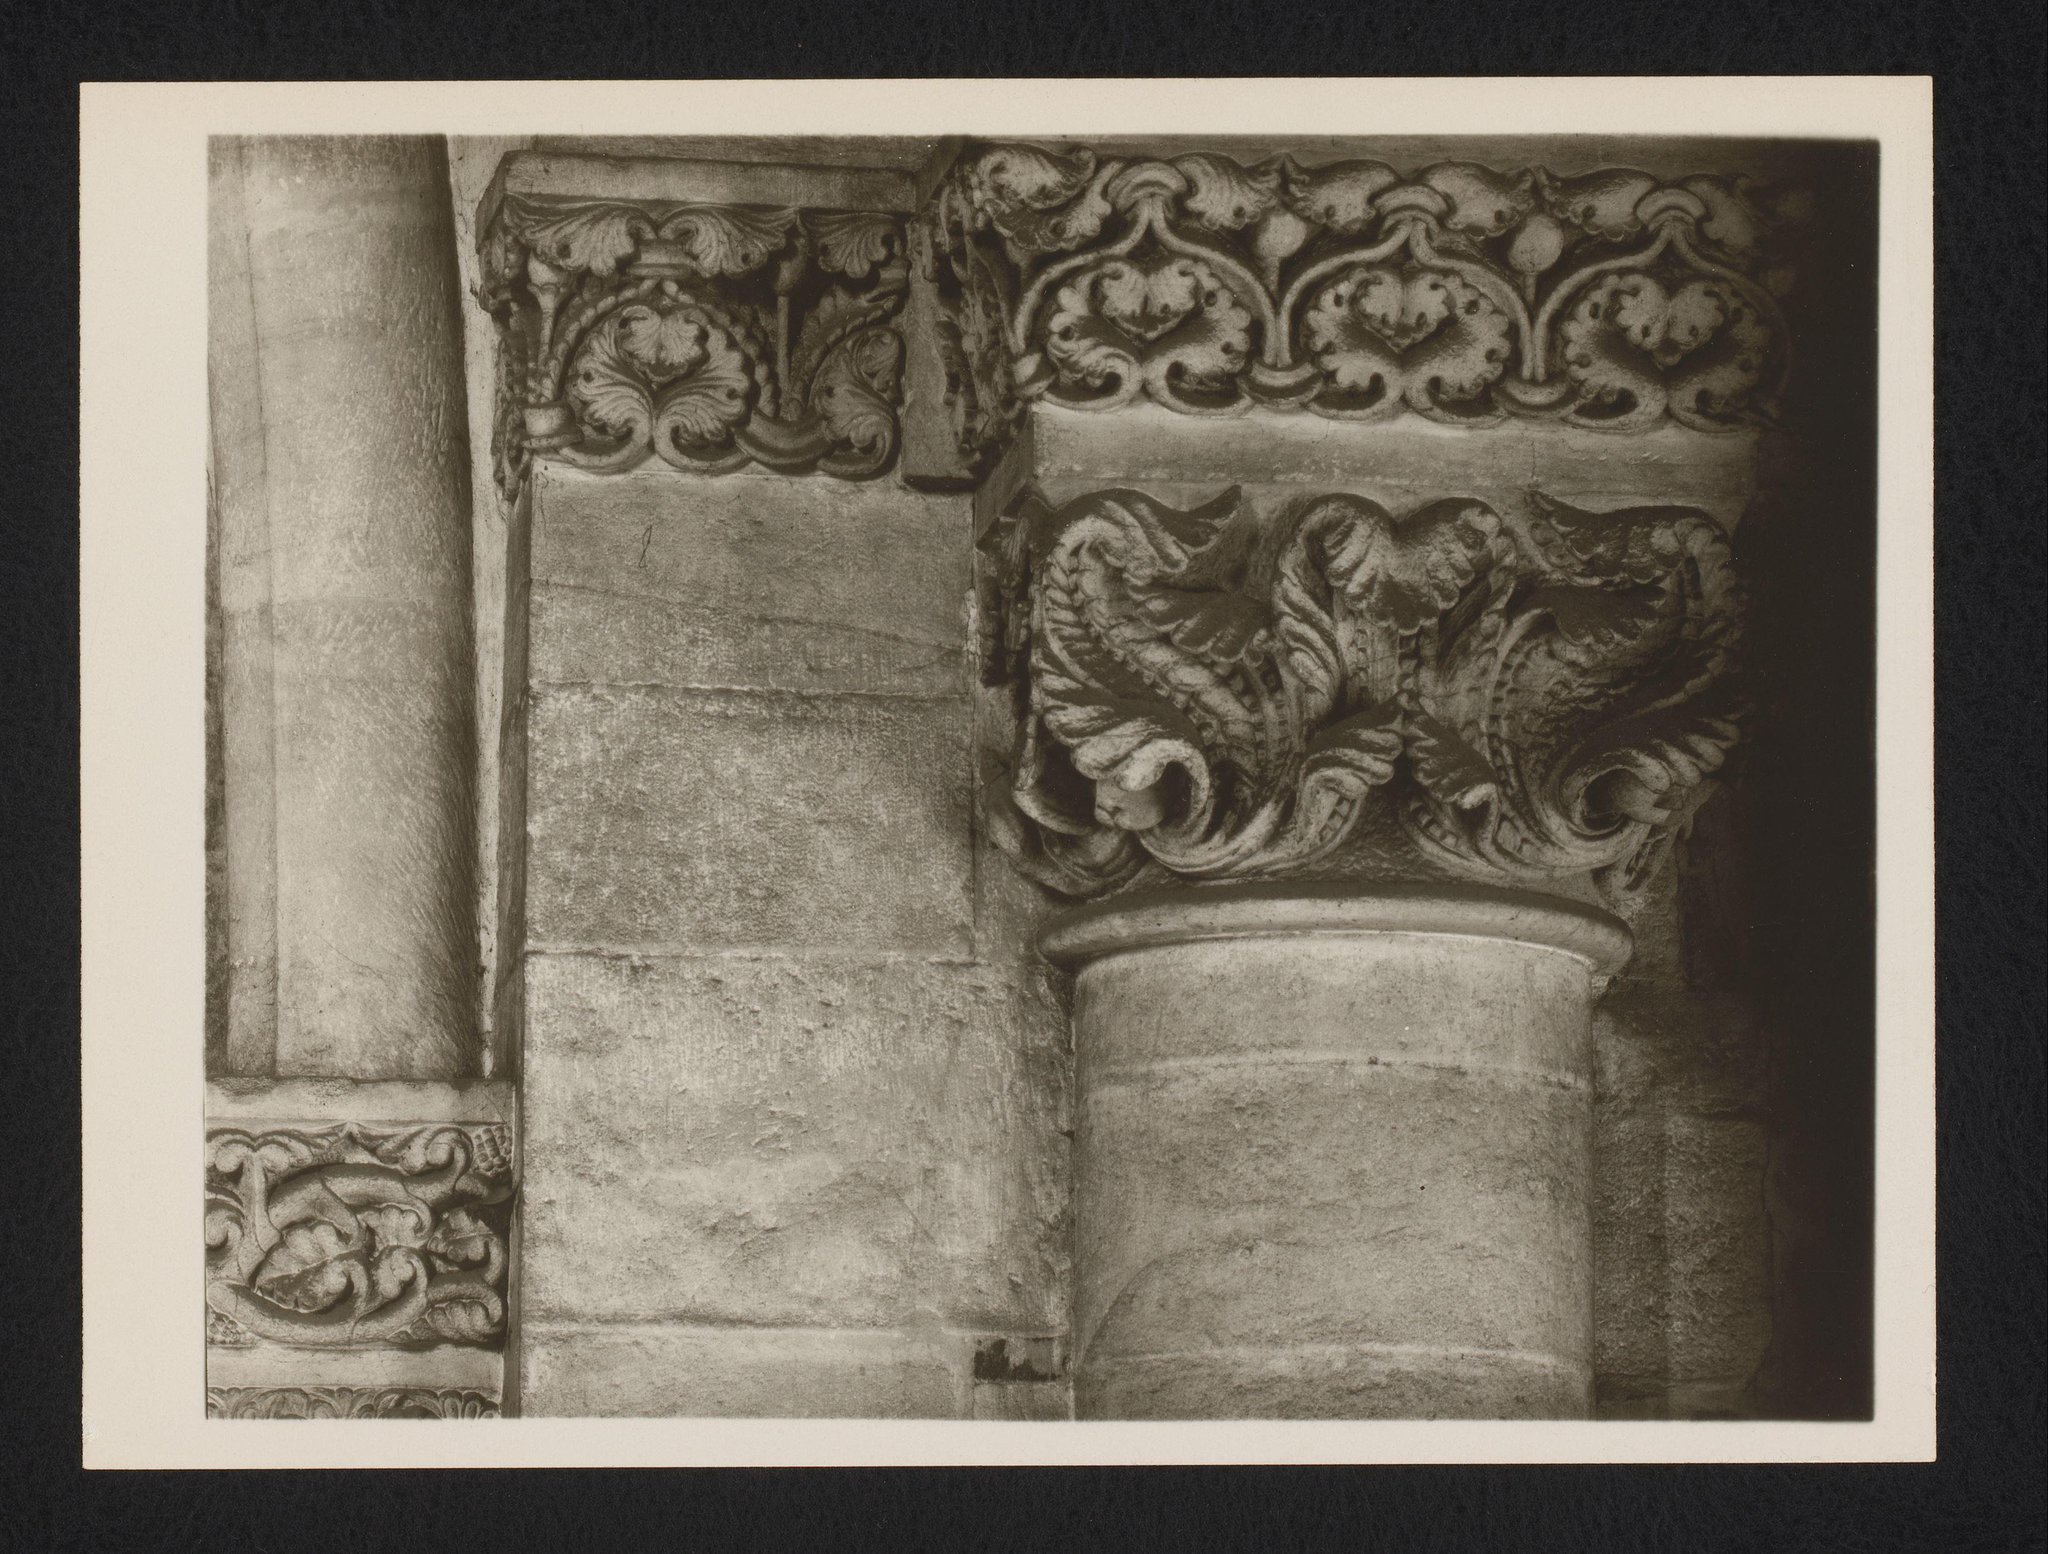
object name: photograph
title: Ostchor, n. Triumphbogenkapitell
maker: Anonymous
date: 1900-1920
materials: paper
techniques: gelatin silver print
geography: bamberg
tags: church (exterior)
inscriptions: inscription: ‘Kunsthist. Seminar/ Marburg (Lahn)/ Photogr. Abteilung/ Vervielfältigung/ untersagt.’